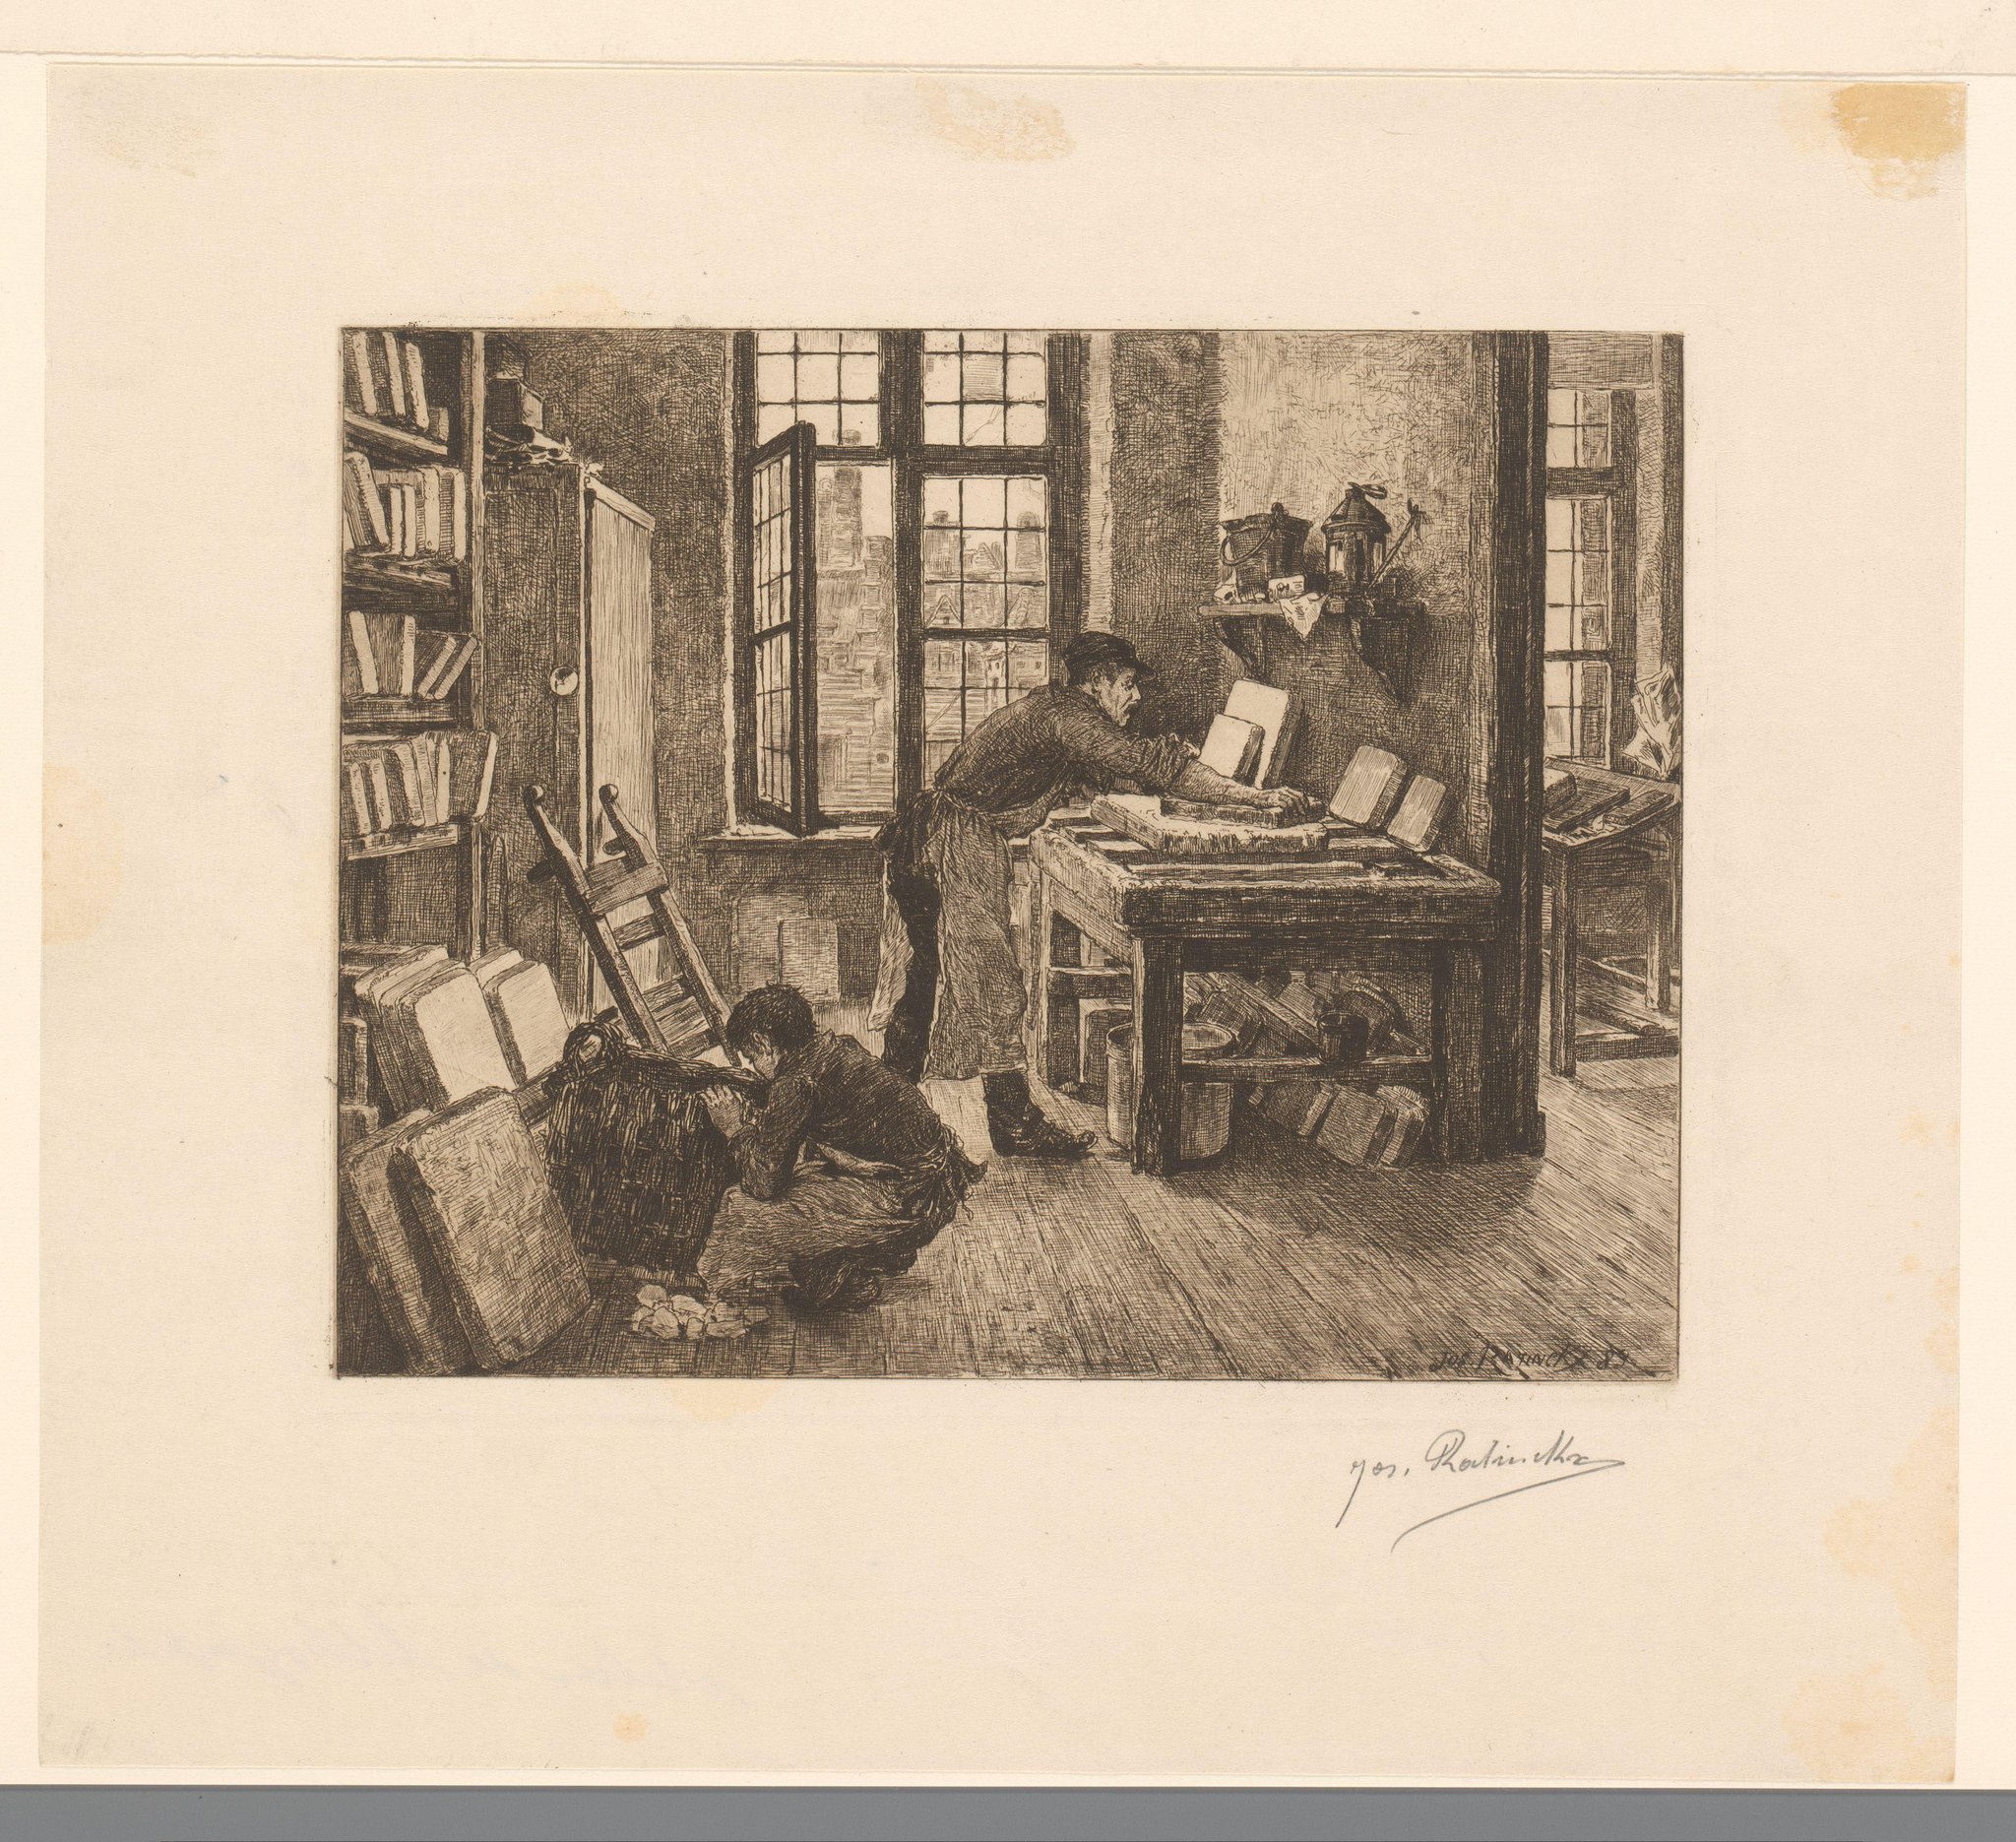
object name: print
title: Lithograaf aan het werk in zijn werkplaats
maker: jos ratinckx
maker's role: print maker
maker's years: 1860-1937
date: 1889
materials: paper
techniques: etching, intaglio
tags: lithographer, artist at work, in his workshop, workshop-interior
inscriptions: mark: ‘Antwerpsche Etsers 1880’, collector's mark: Lugt 2228